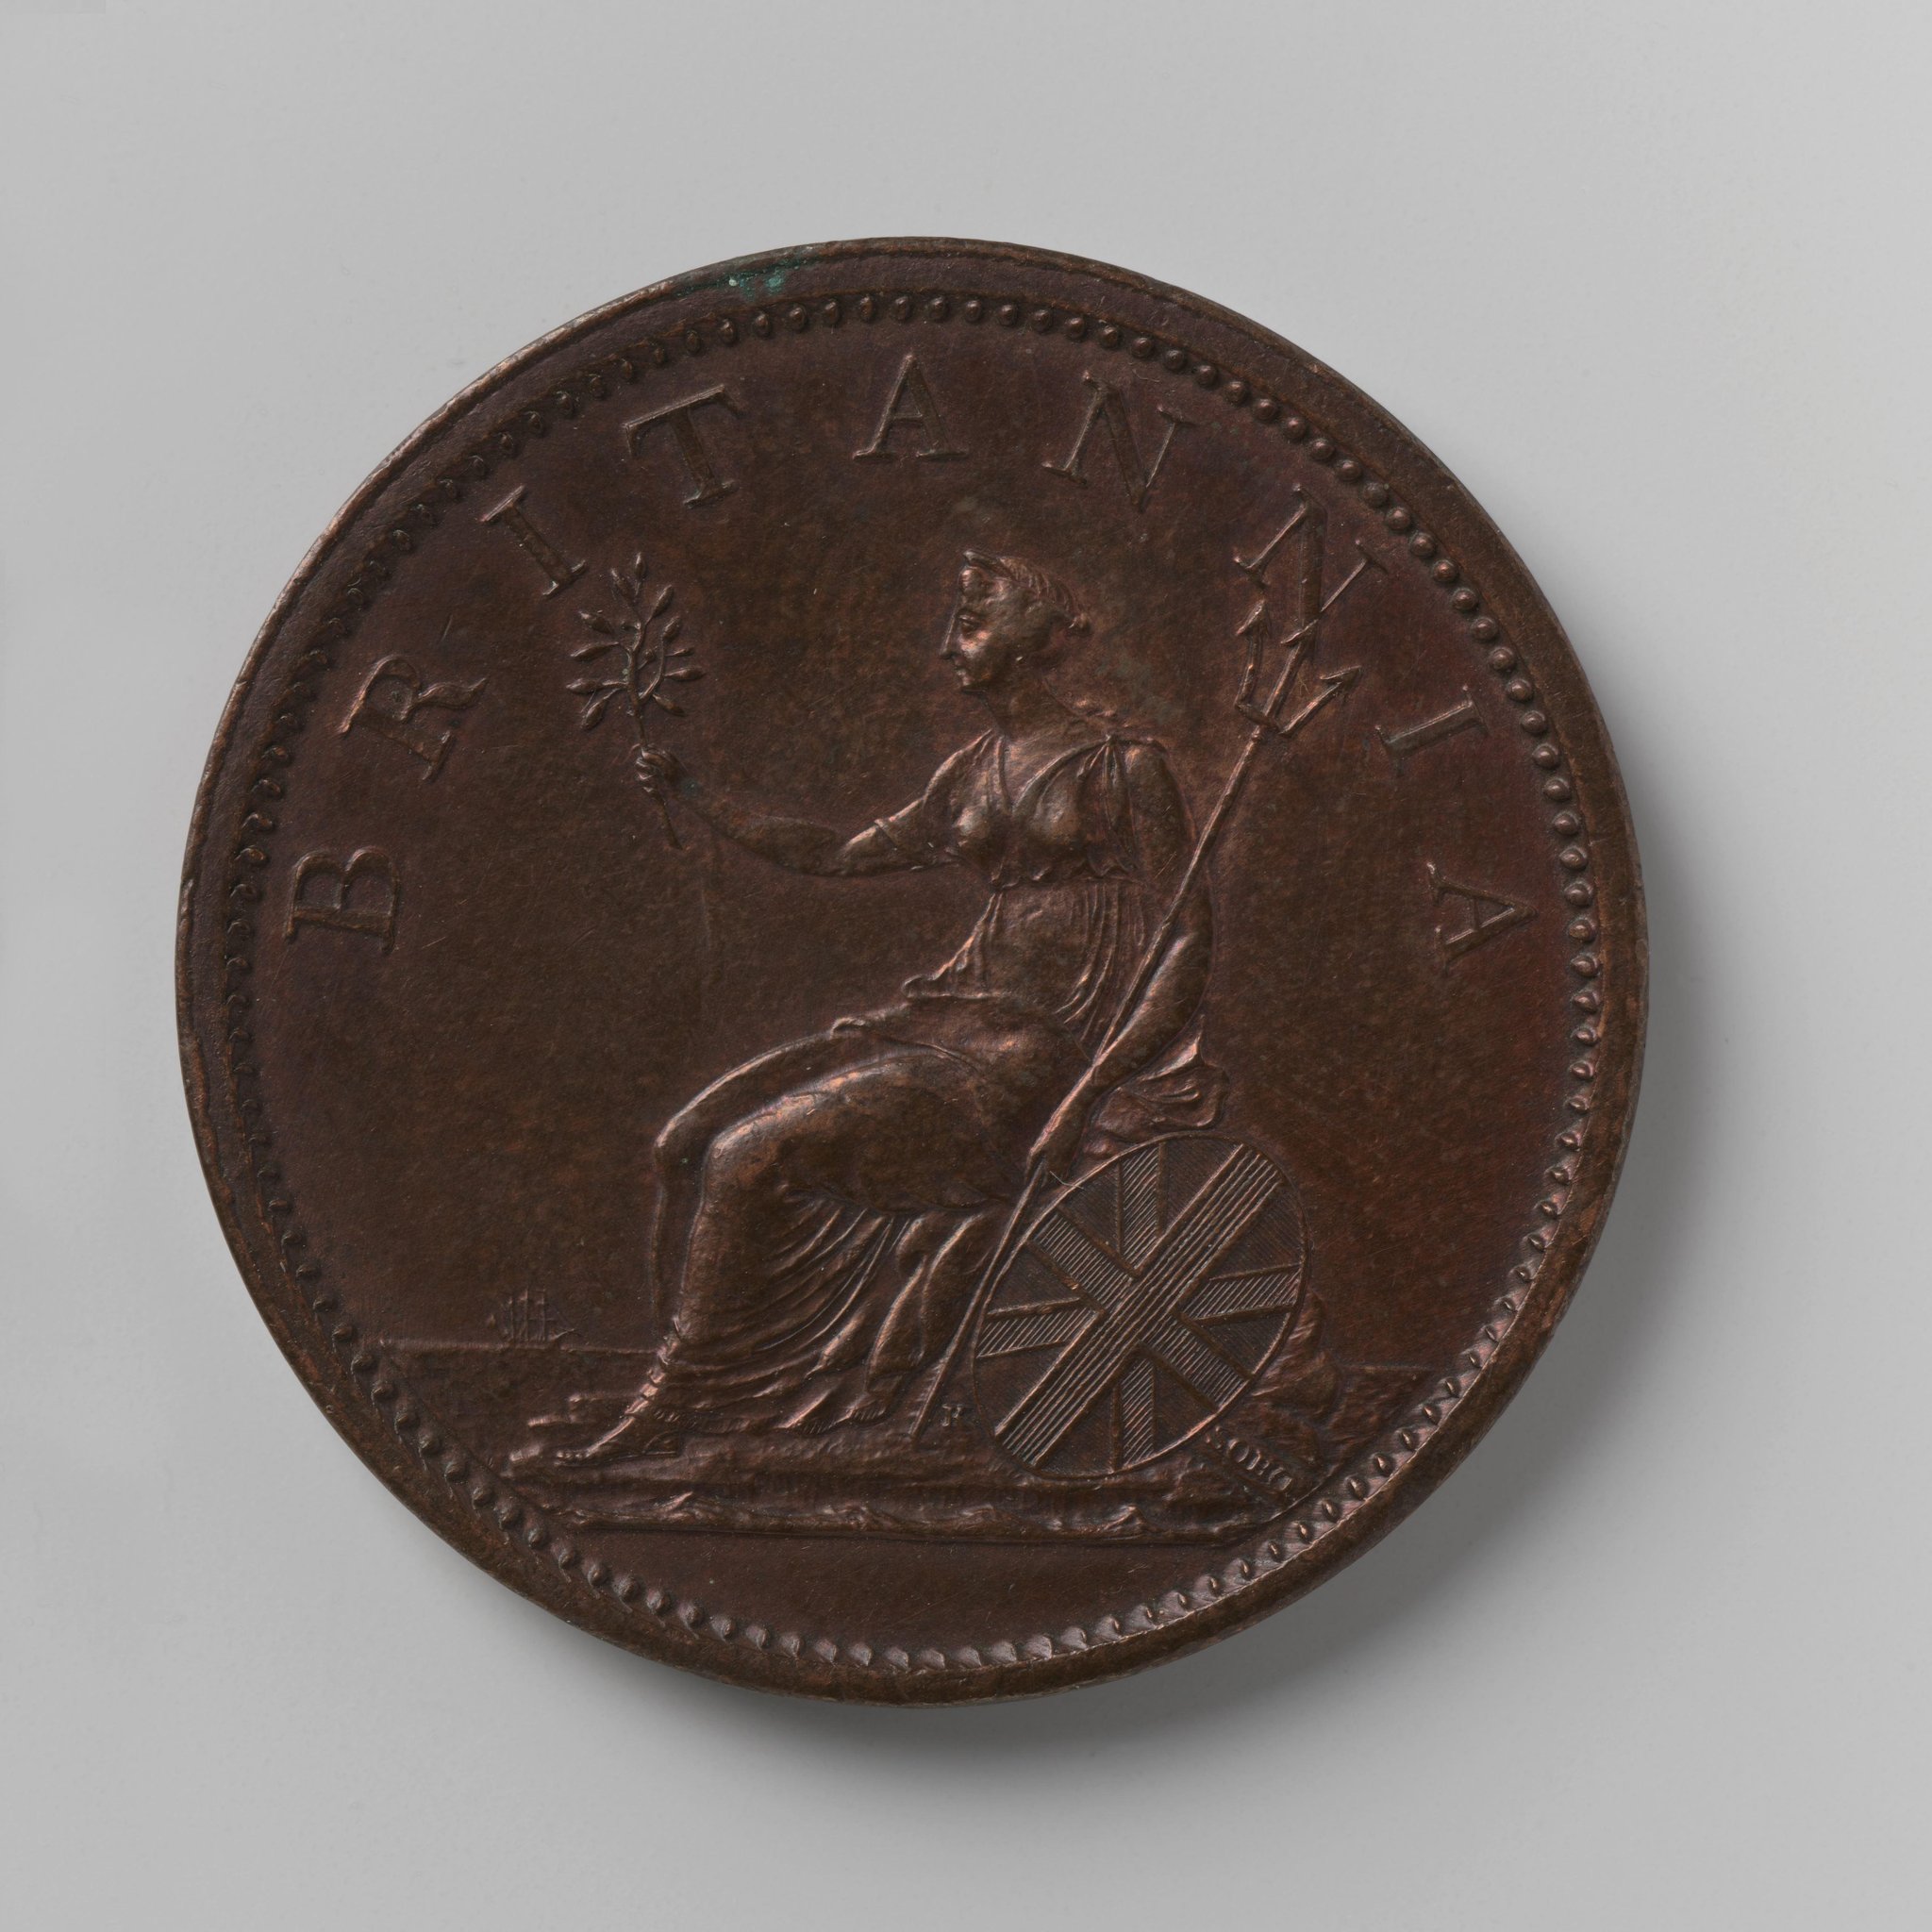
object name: coin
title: Penny uit Engeland van George III, 1806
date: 1806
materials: copper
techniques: striking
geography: birmingham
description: Koperen munt. Voorzijde: gelauwerd borstbeeld van de koning naar rechts. Jaartal in omschrift onderaan. Keerzijde: op rots, waartegen schild geplaatst, gezeten Brittannia met drietand en tak, naar links. Links van har schip. Kartelrand.